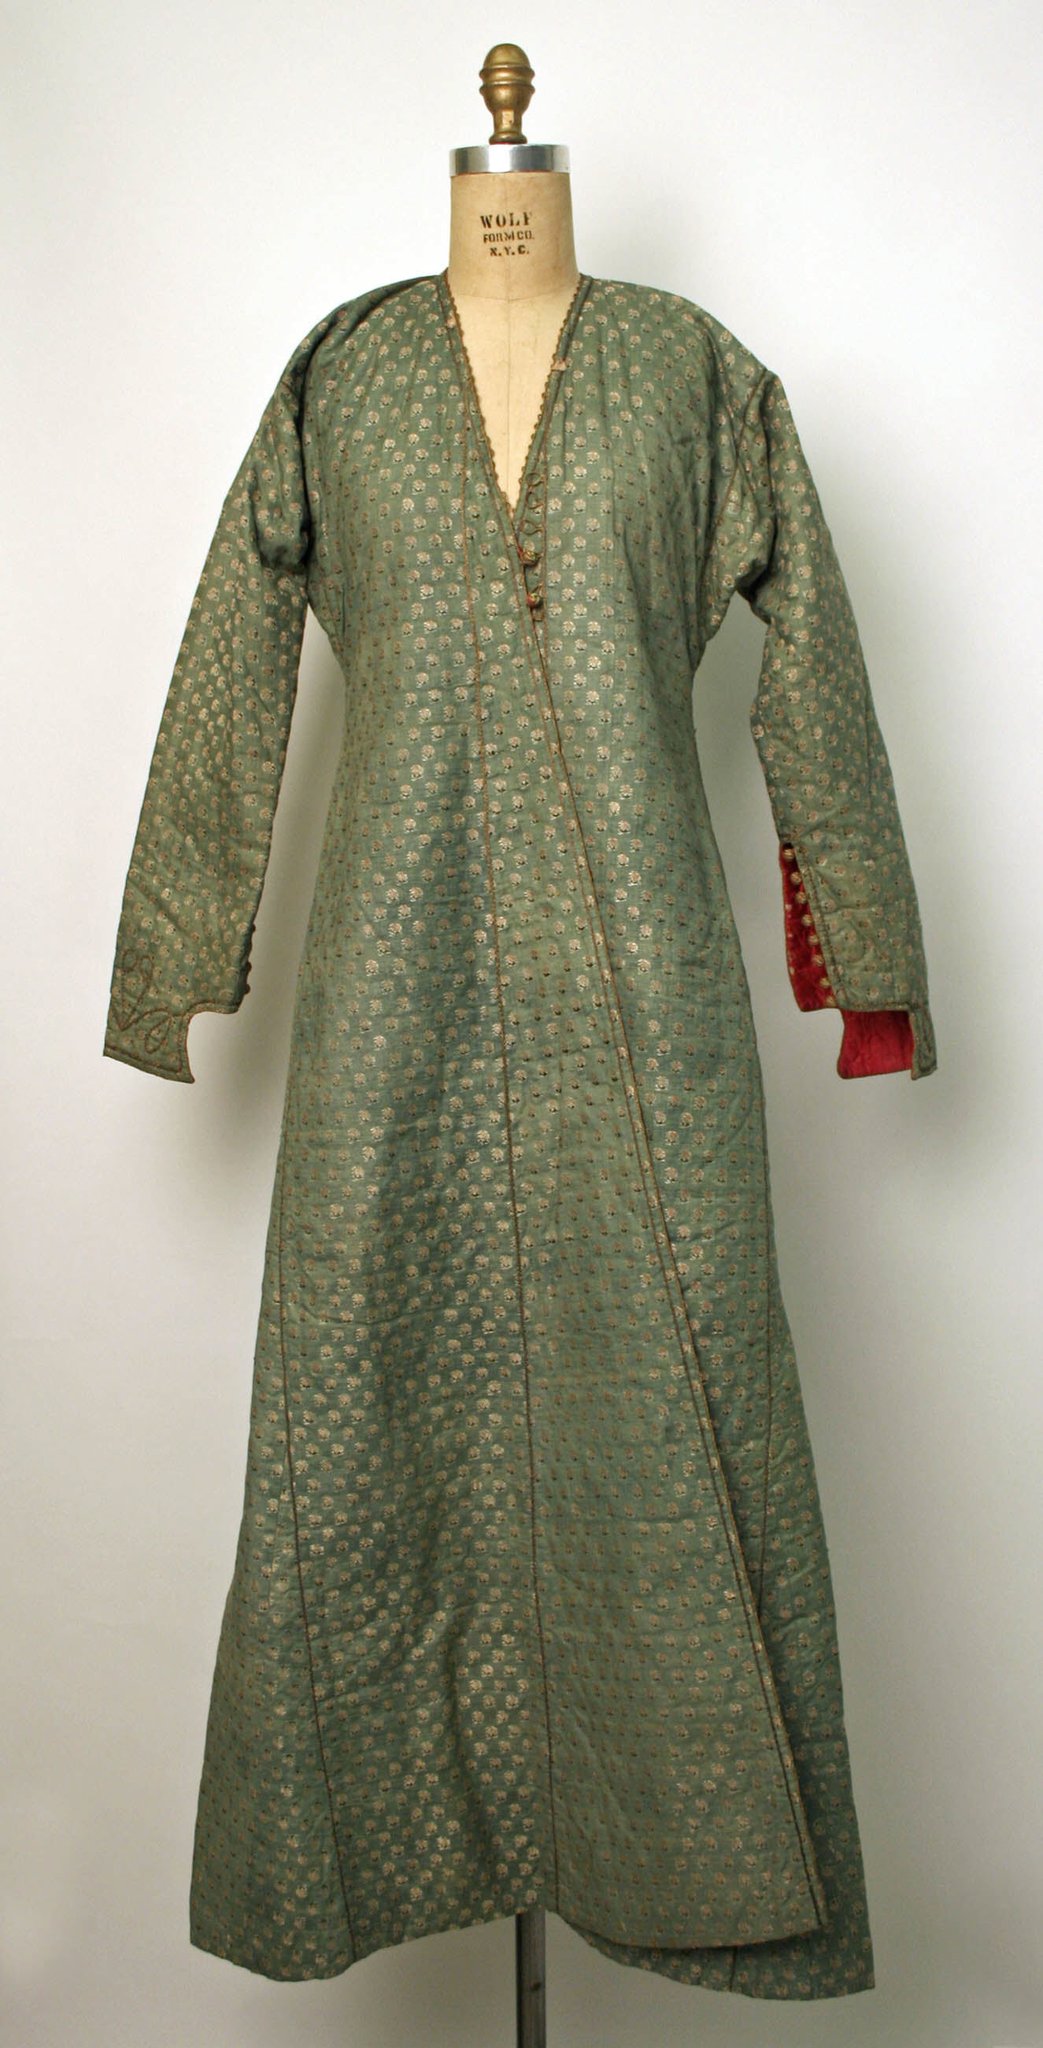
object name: robe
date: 1801-1833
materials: cotton, metal, silk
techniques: treatment, weave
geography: italy